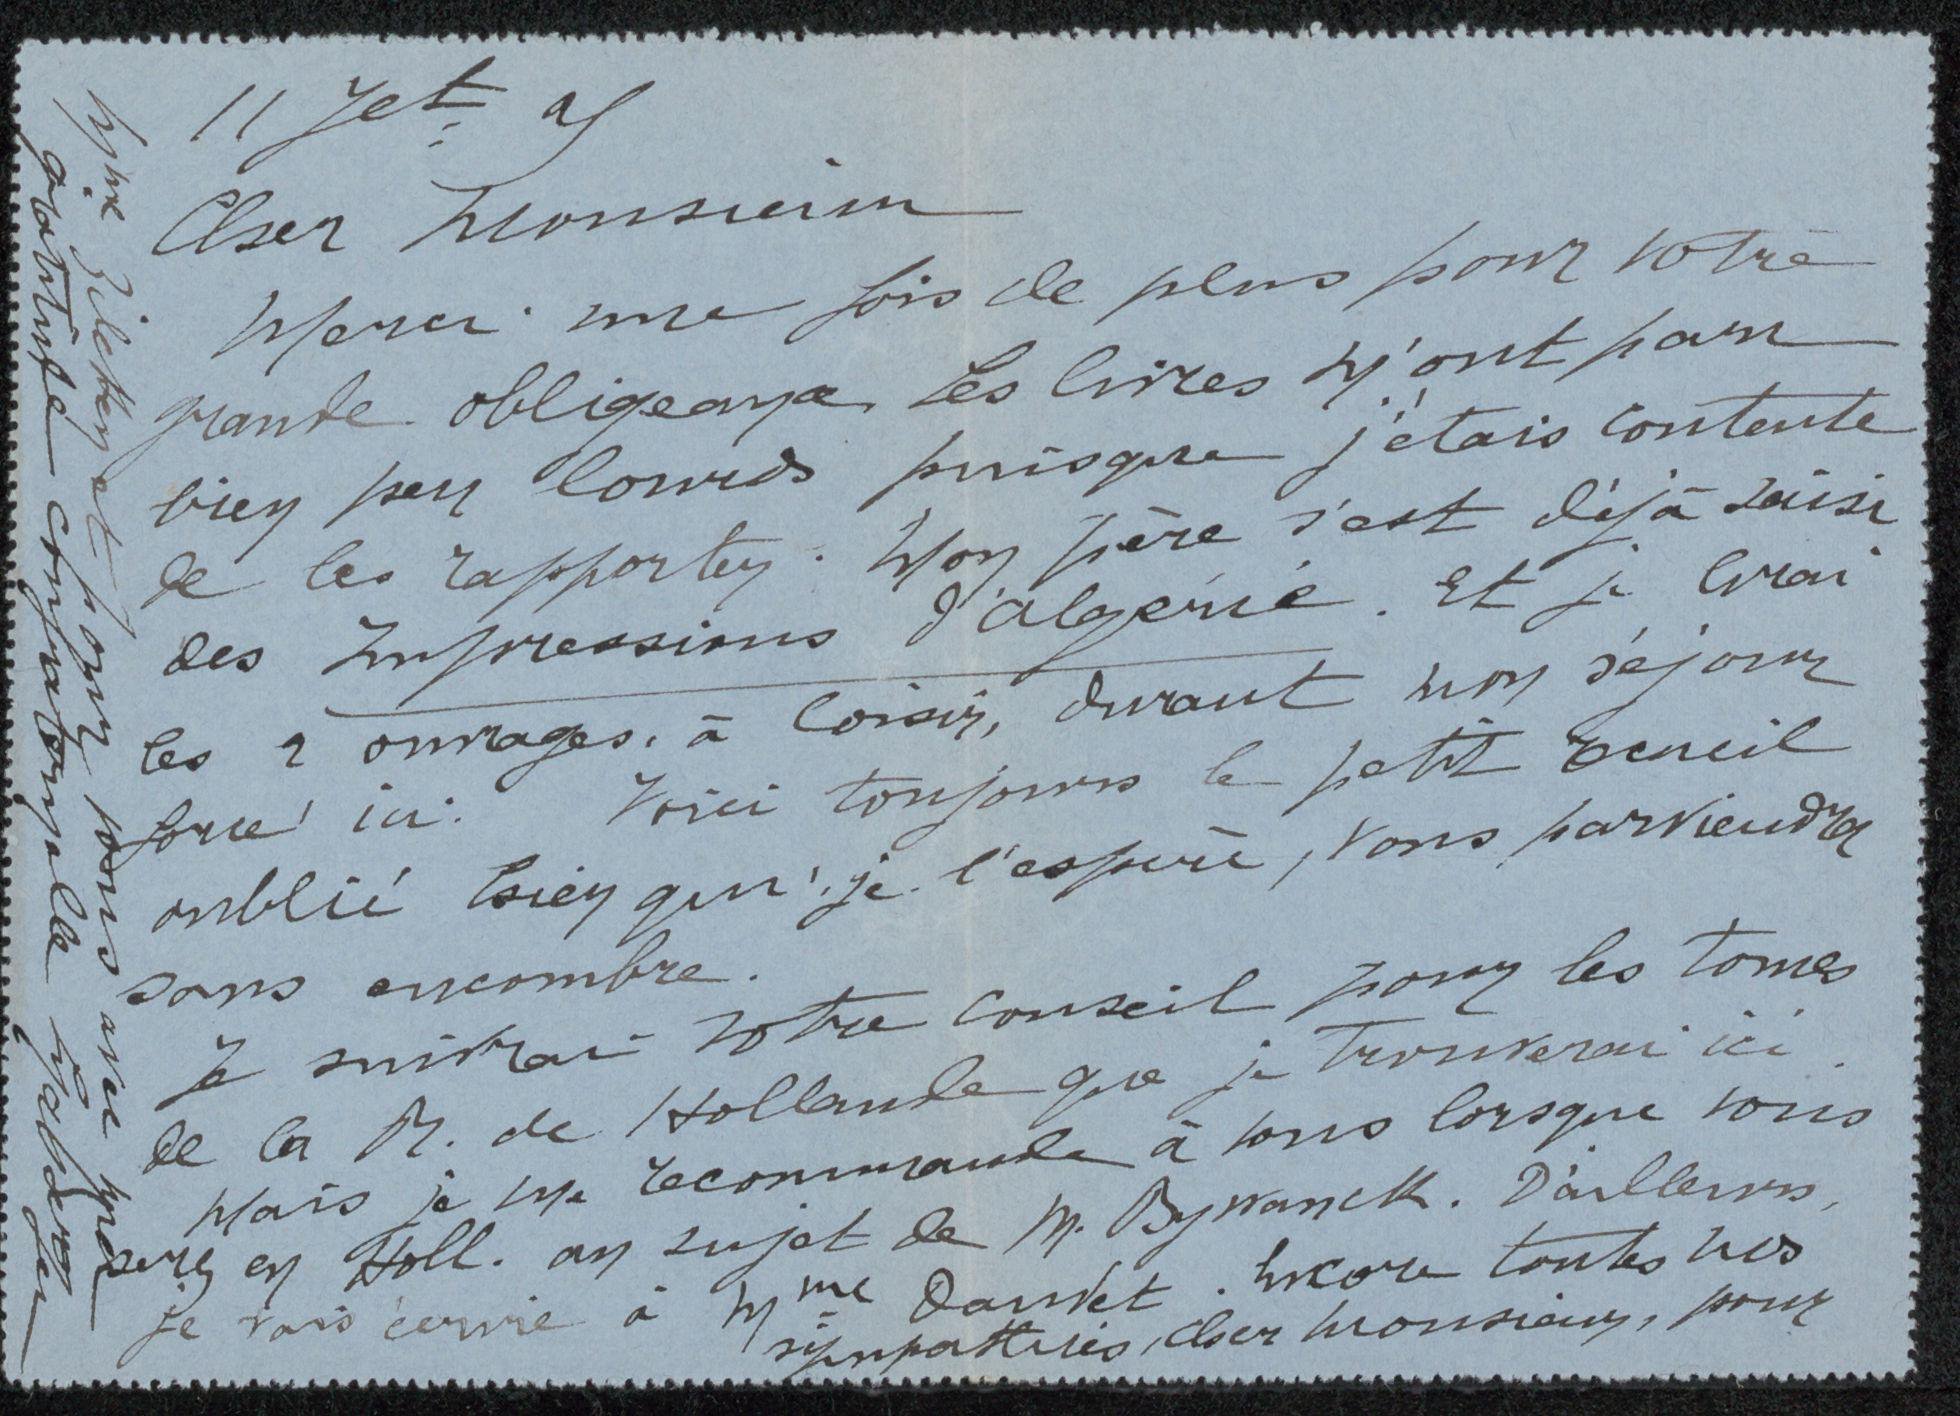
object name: letter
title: Brief aan Philip Zilcken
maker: lya berger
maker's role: schrijver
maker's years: 1877-1941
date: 1925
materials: ink, paper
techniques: pen, writing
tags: amsterdam, willem byvanck, painter, draughtsman, philip zilcken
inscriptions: collector's mark: ‘RPK’